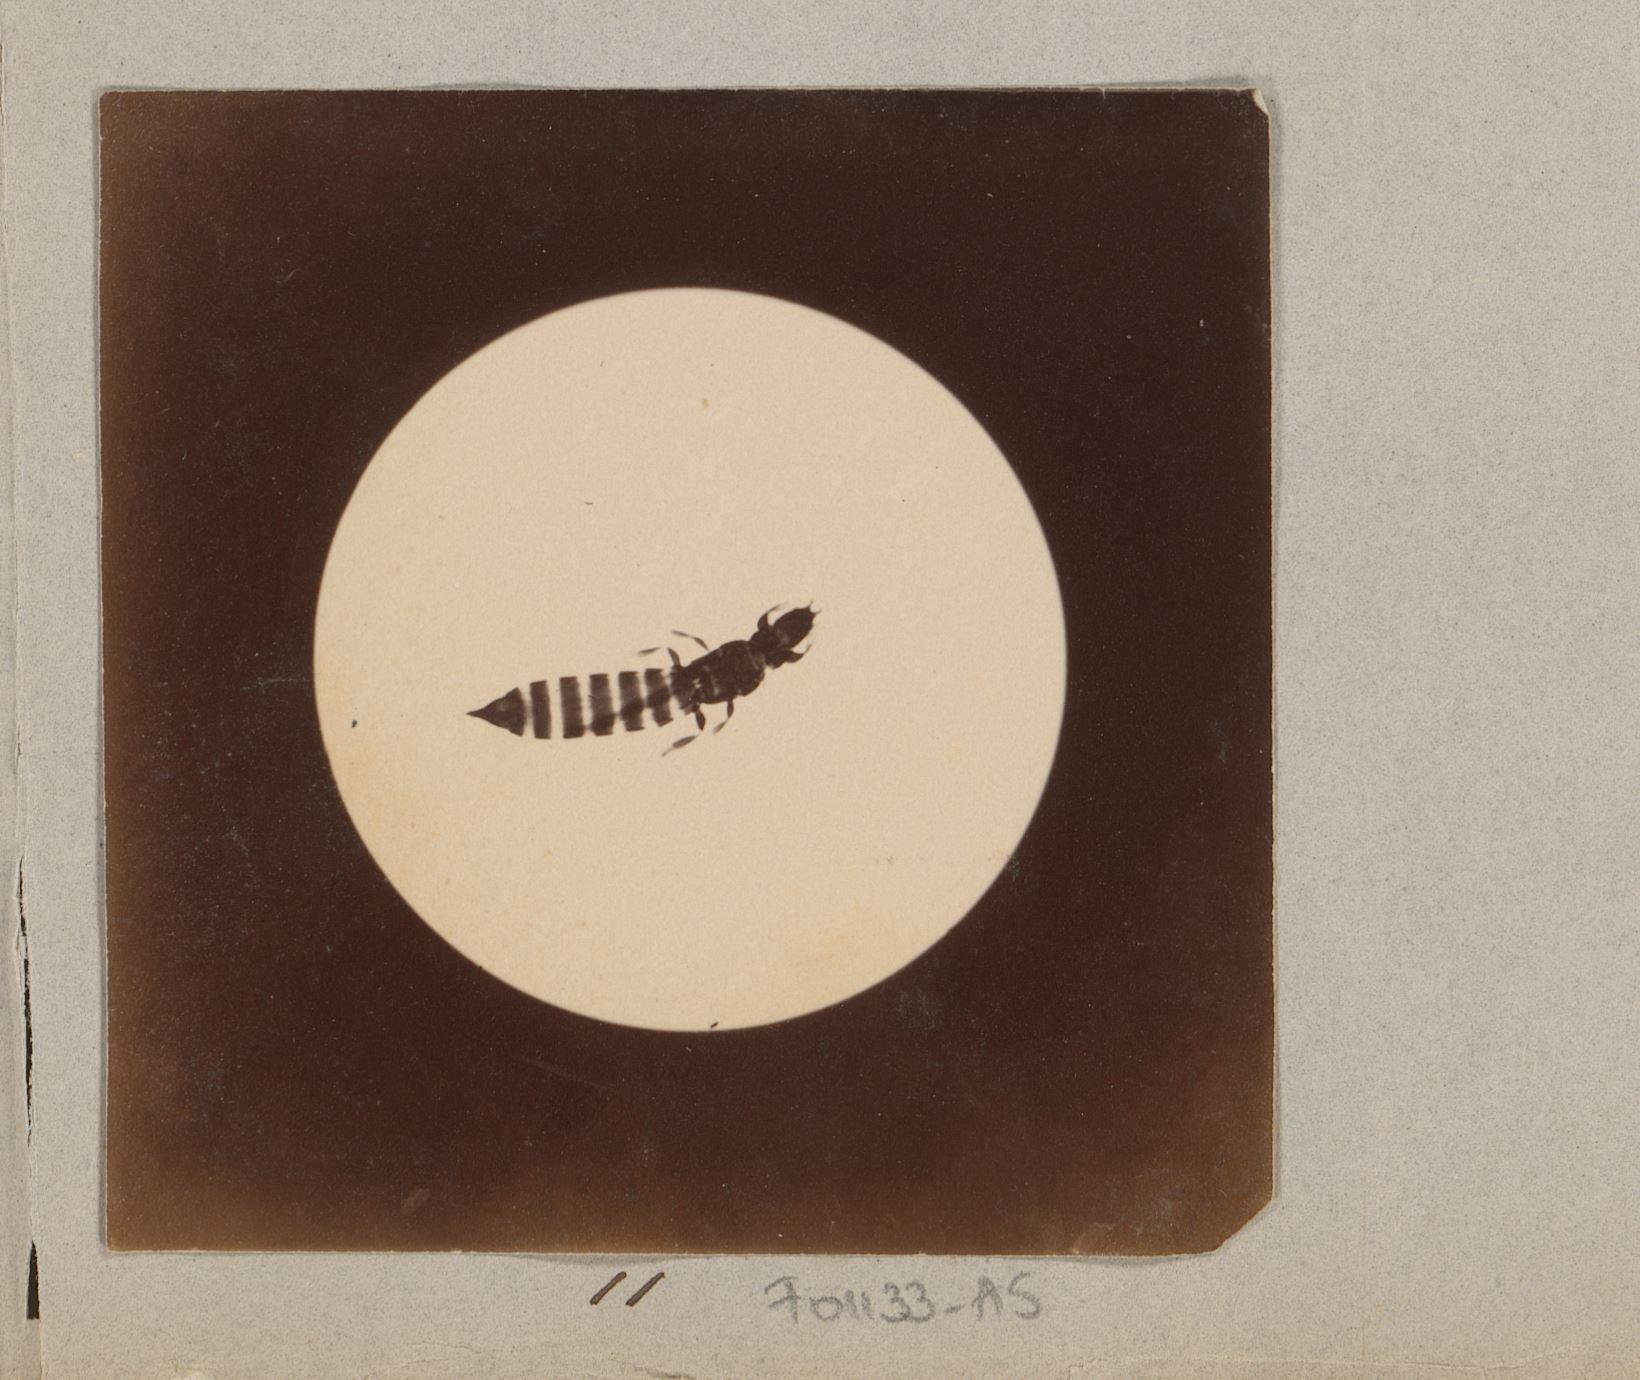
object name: photograph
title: Microscopische opname van kleine watertor, vijftien keer vergroot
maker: marinus pieter filbri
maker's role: instrument maker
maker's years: 1852-1917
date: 1887-1888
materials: paper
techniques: albumen print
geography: netherlands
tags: insects, netherlands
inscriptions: number: ‘11’, inscription: ‘No. 11. Benaming Kleine Watertor, 15 x vergroot, pose 3 min., bemerking id. id.’